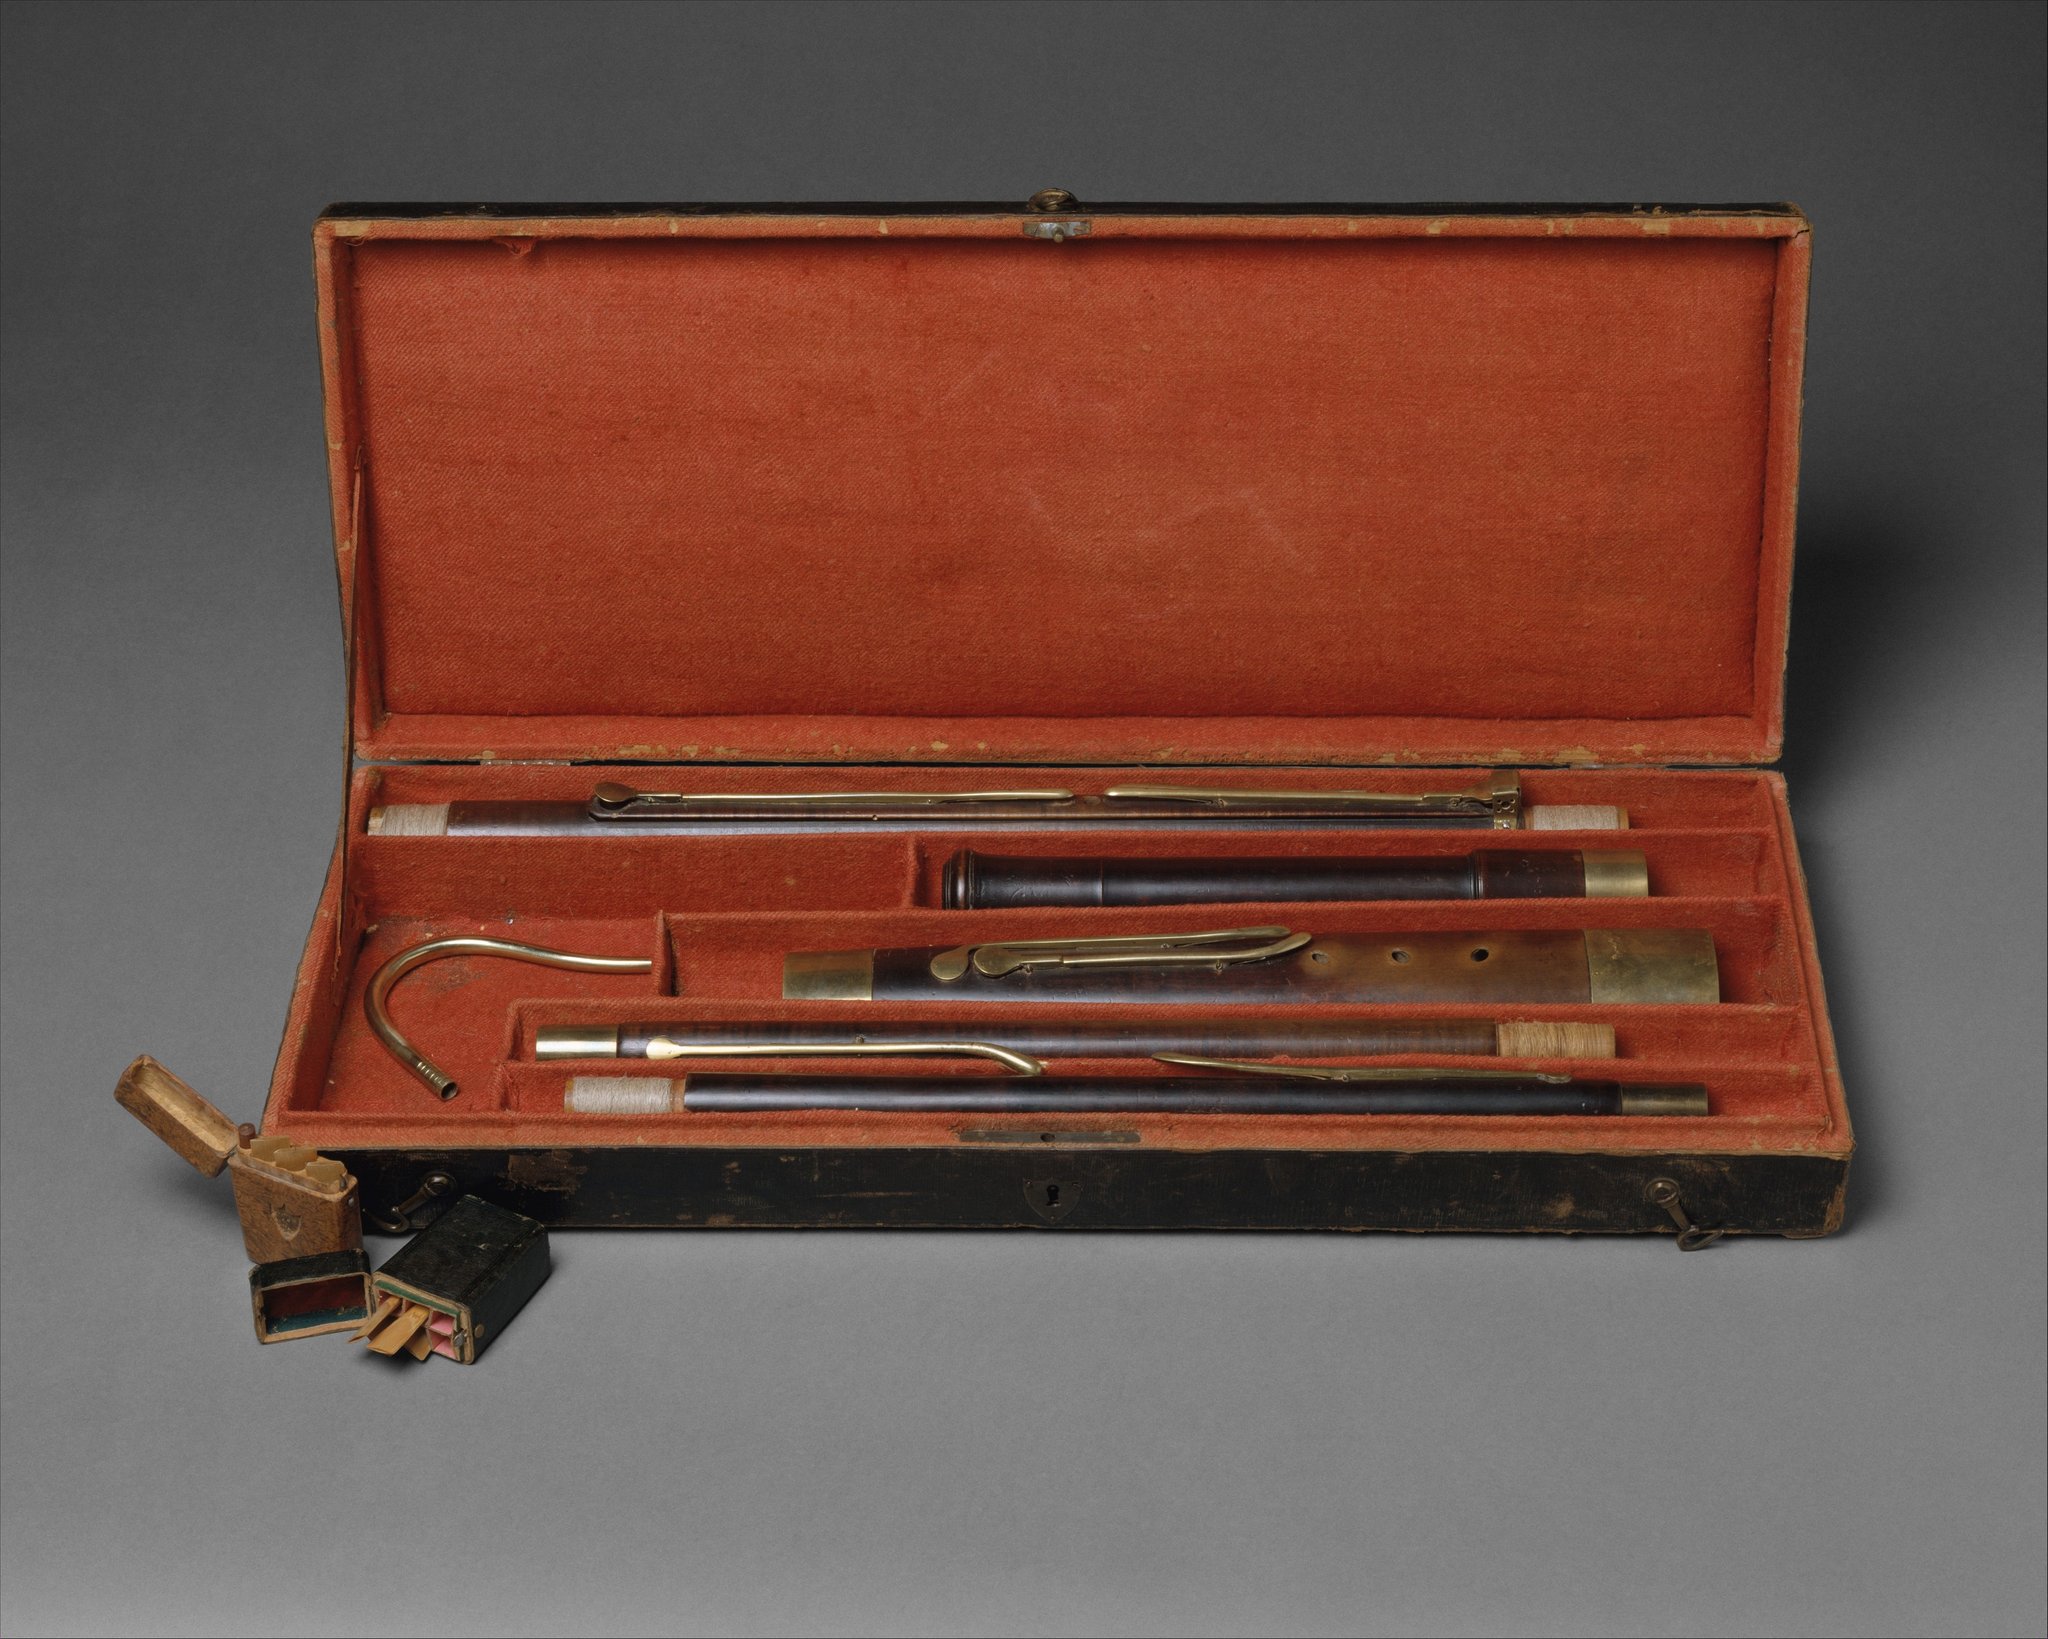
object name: bassoon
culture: french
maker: dominique antony porthaux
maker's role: maker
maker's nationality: french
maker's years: 1751-1839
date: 1790-1800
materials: brass, wood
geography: france